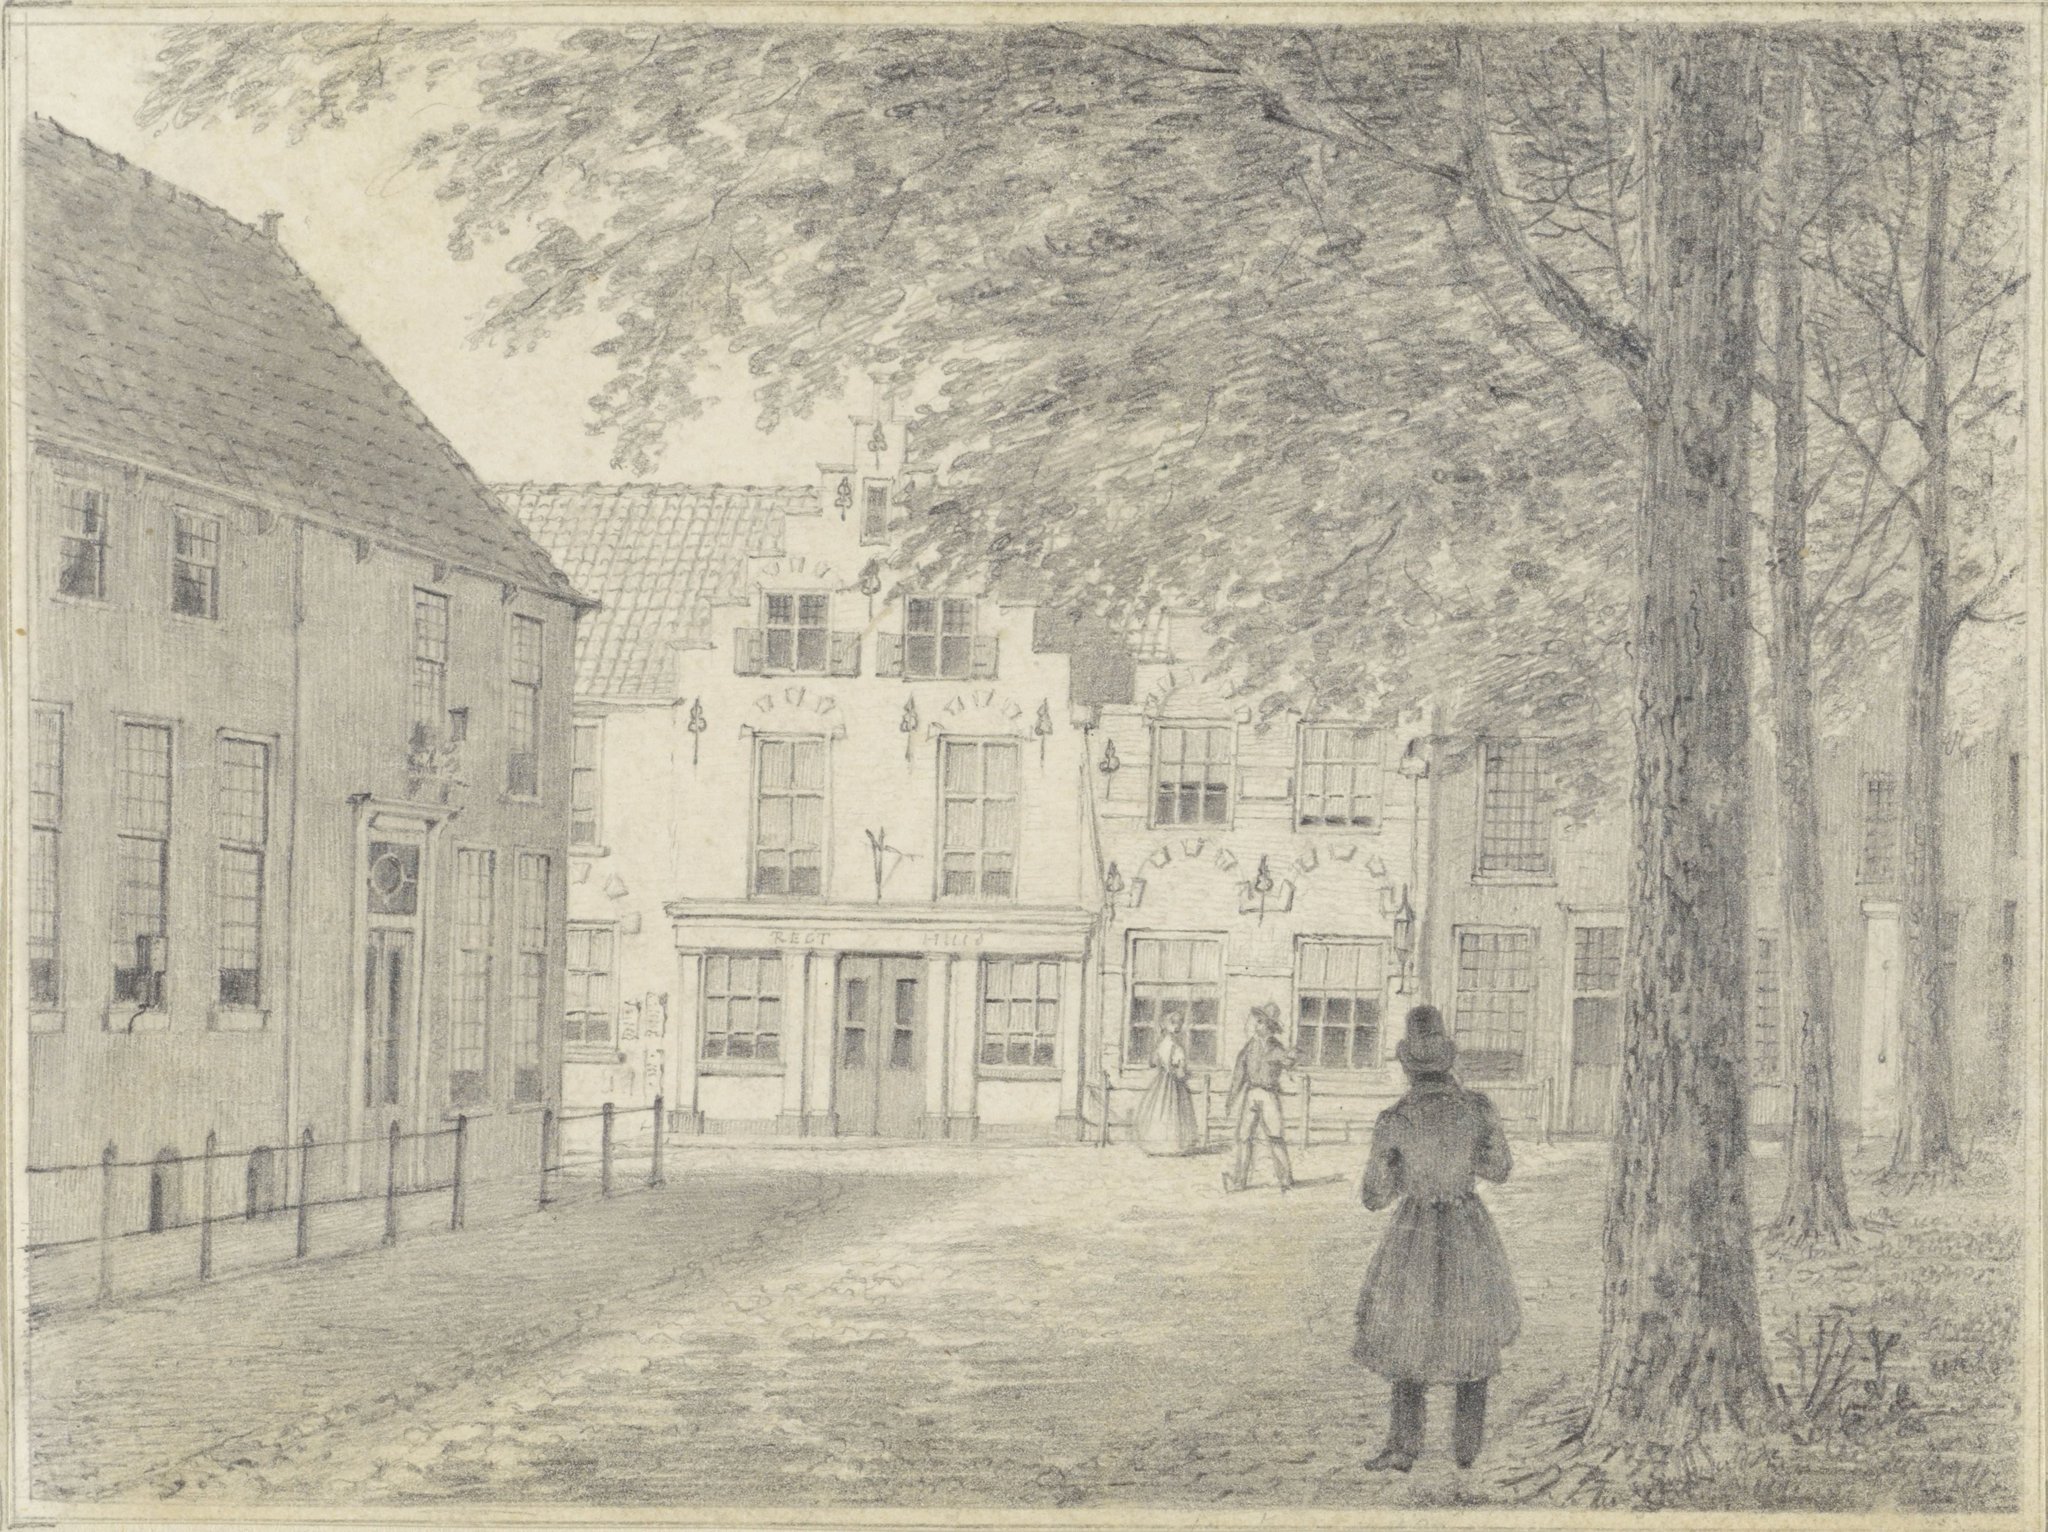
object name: drawing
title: Gezicht te Rijswijk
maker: hendrik abraham klinkhamer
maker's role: draughtsman, painter, print maker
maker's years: 1810-1872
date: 1839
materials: paper, pencil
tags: street